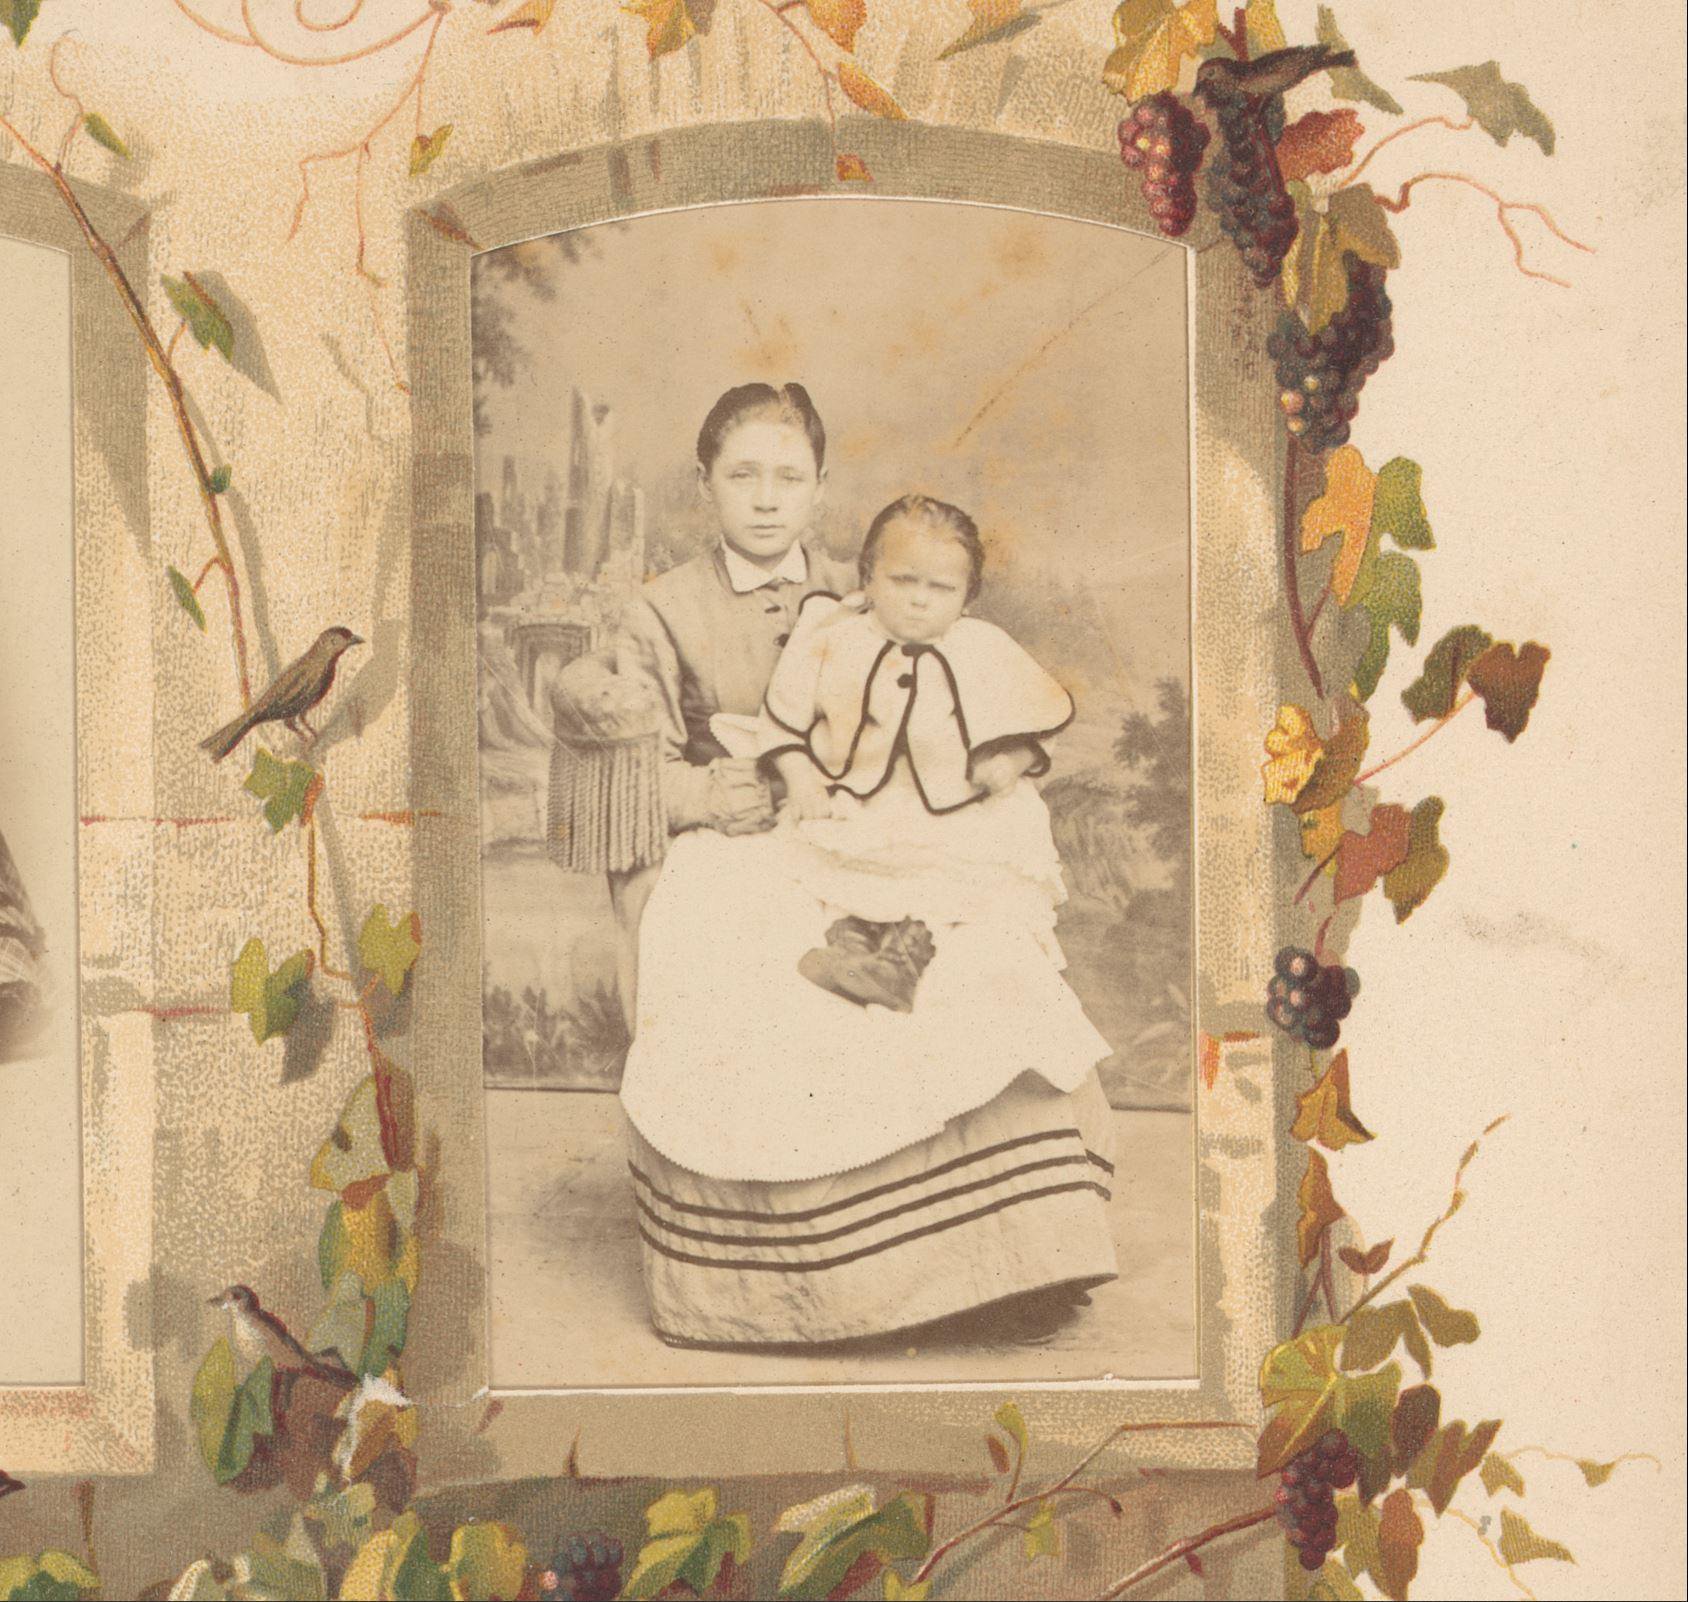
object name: carte de visite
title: Portret van een vrouw met een peuter op schoot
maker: l. strieckling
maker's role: fotograaf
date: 1866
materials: cardboard, photographic support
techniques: albumen print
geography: bad oeynhausen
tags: historical persons - bb - woman, tot, toddler ~ the ages of man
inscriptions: inscription: ‘ATELIER FÜR/ Portrait- u. Landschaft/ PHOTOGRAPHIE/ L. Strieckling/ Photograph/ Bad Oeynhausen.’, annotation: ‘[.]aiterin [..]/ Mutter!’